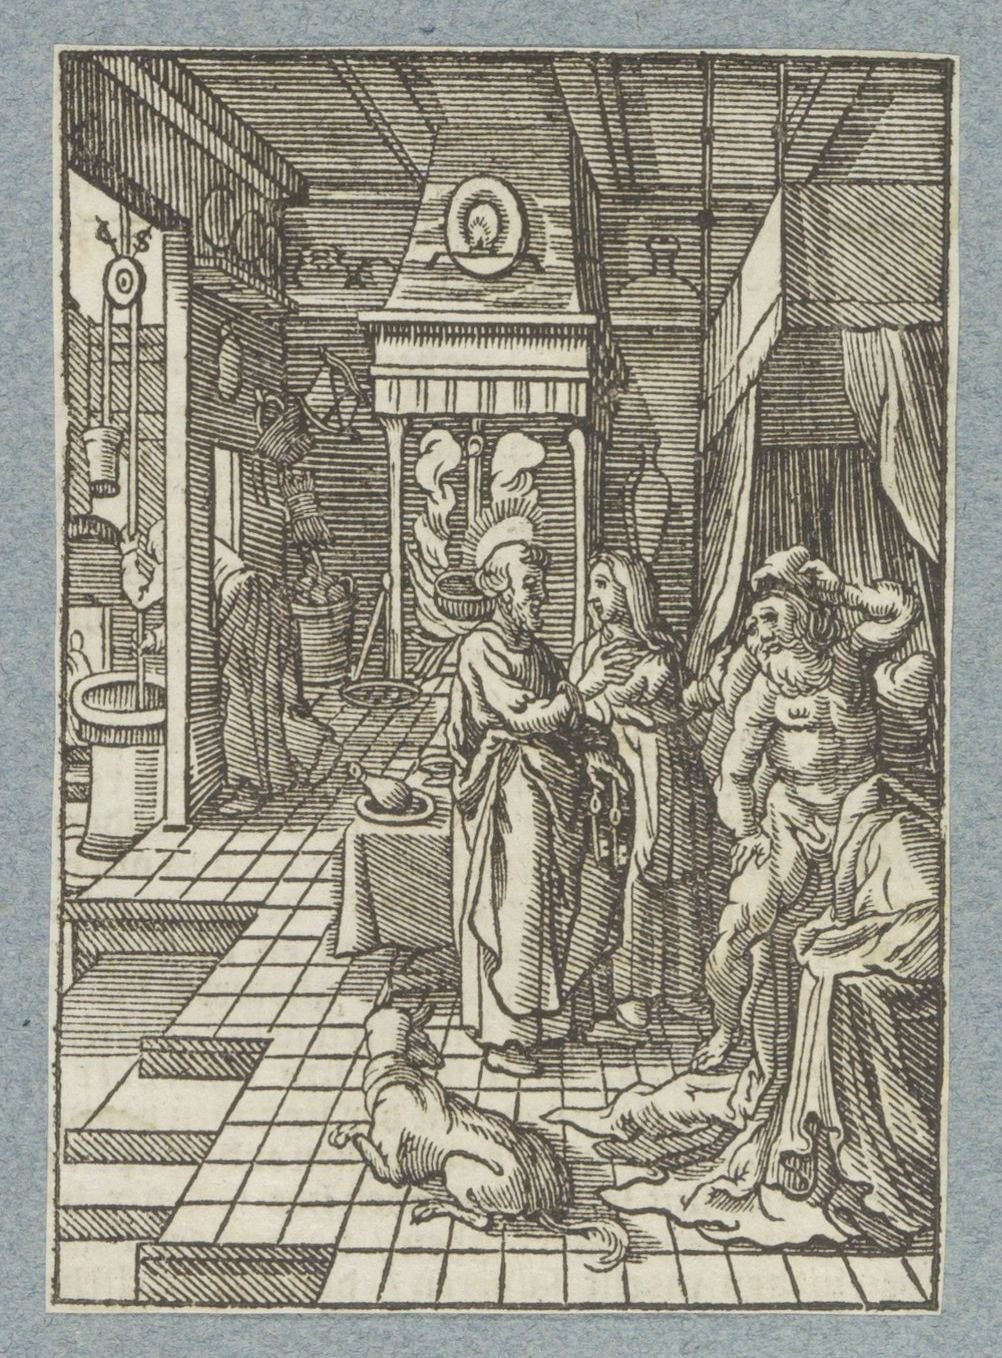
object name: print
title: Petrus geneest Eneas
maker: pieter jacobsz. paets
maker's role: publisher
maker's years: 1587-1667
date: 1629-1646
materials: paper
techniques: letterpress printing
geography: haarlem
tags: peter in lydda heals aeneas, who had been confined to his bed for eight years (acts 9:32-35)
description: De prent is afkomstig uit een van de uitgaven van P.J. Paets uit Amsterdam. De prent wordt mogelijk al gebruikt in: Der Zielen Lust-hof. Leuven, I.Jacbosz voor P.J. Paets [= Amsterdam, P.J. Paets], 1629. Ze komt in ieder geval voor in: Het Nieuwe Testament ons Salichmaeckers Jesu Christi. Amsterdam, P.J. Paets, 1646. De voorstelling is gekopieerd naar een prent van Philips Galle naar Maarten van Heemskerck, onderdeel van de serie getiteld Acta Apostolorum.